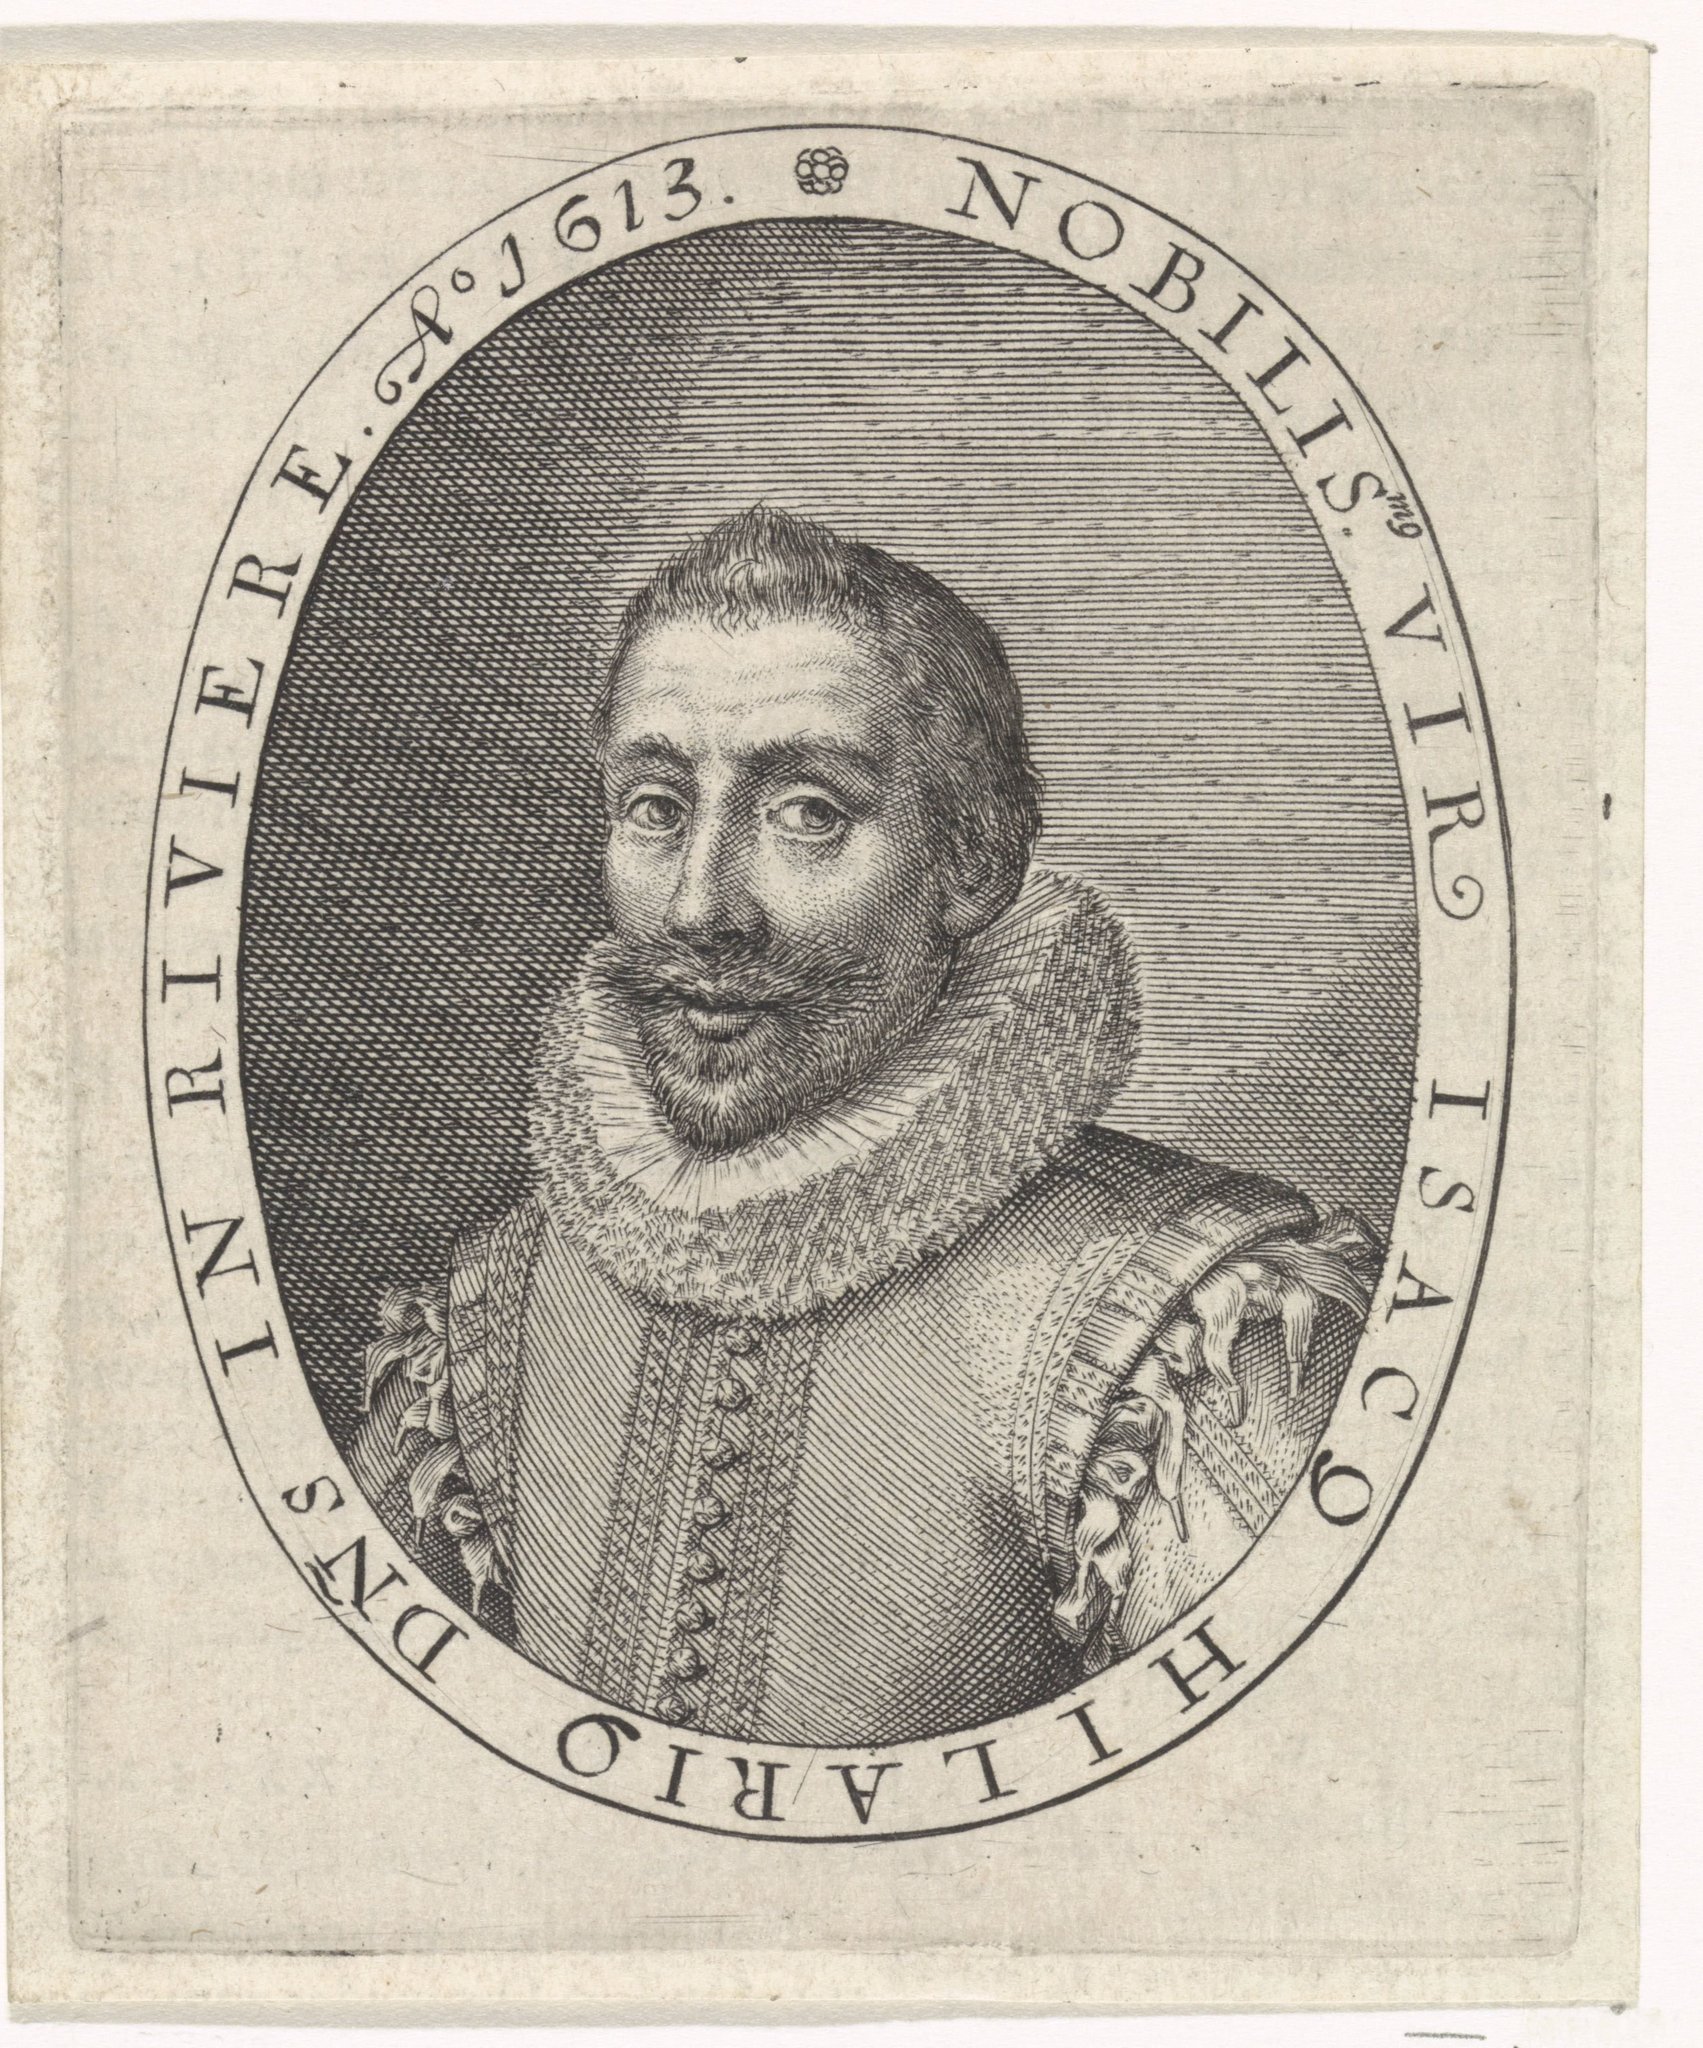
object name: book illustration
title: Portret van Isaac Hilaire de la Rivière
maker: crispijn van de passe (i)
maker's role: draughtsman, print maker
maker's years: 1564-1637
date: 1613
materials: paper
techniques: engraving, letterpress printing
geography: utrecht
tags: schrijver, isaac hilaire de la rivière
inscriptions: inscription: ‘F 660’, collector's mark: Lugt 240, inscription: ‘38-69’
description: Portret van de schrijver Isaac Hilaire de la Rivière. In het randschrift van de omlijsting de naam van de geportretteerde in het Latijn. Op de versozijde boekdruk in het Latijn over de Trojaanse oorlog.